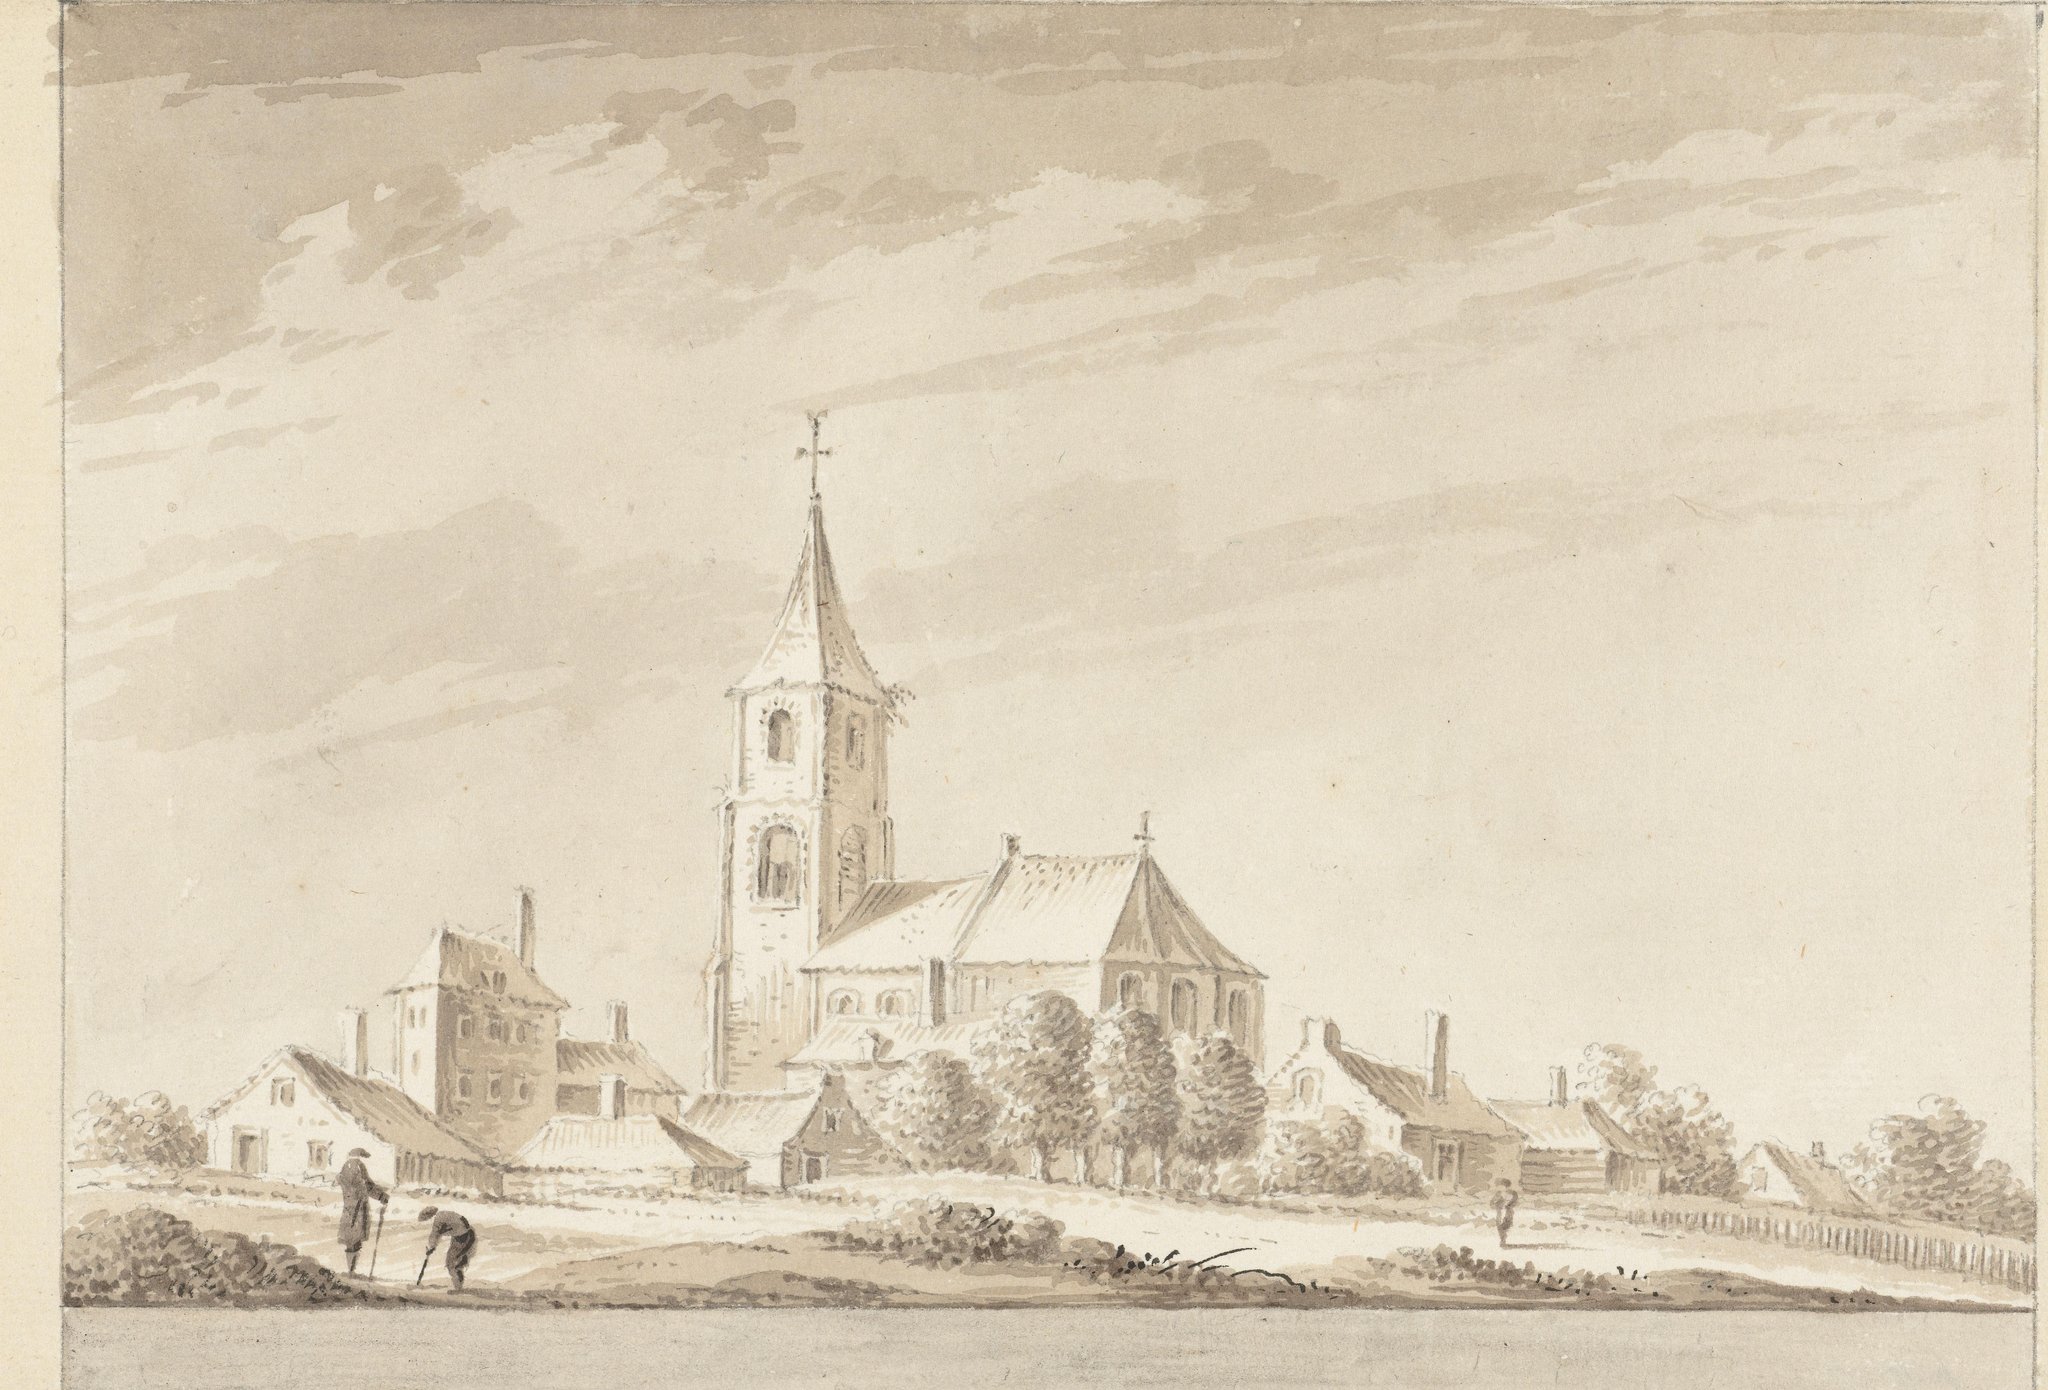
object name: drawing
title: Nieuwerkerk te Duiveland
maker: cornelis pronk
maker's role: draughtsman, painter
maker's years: 1691-1759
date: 1735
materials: paper, pencil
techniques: brush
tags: prospect of village, silhouette of village